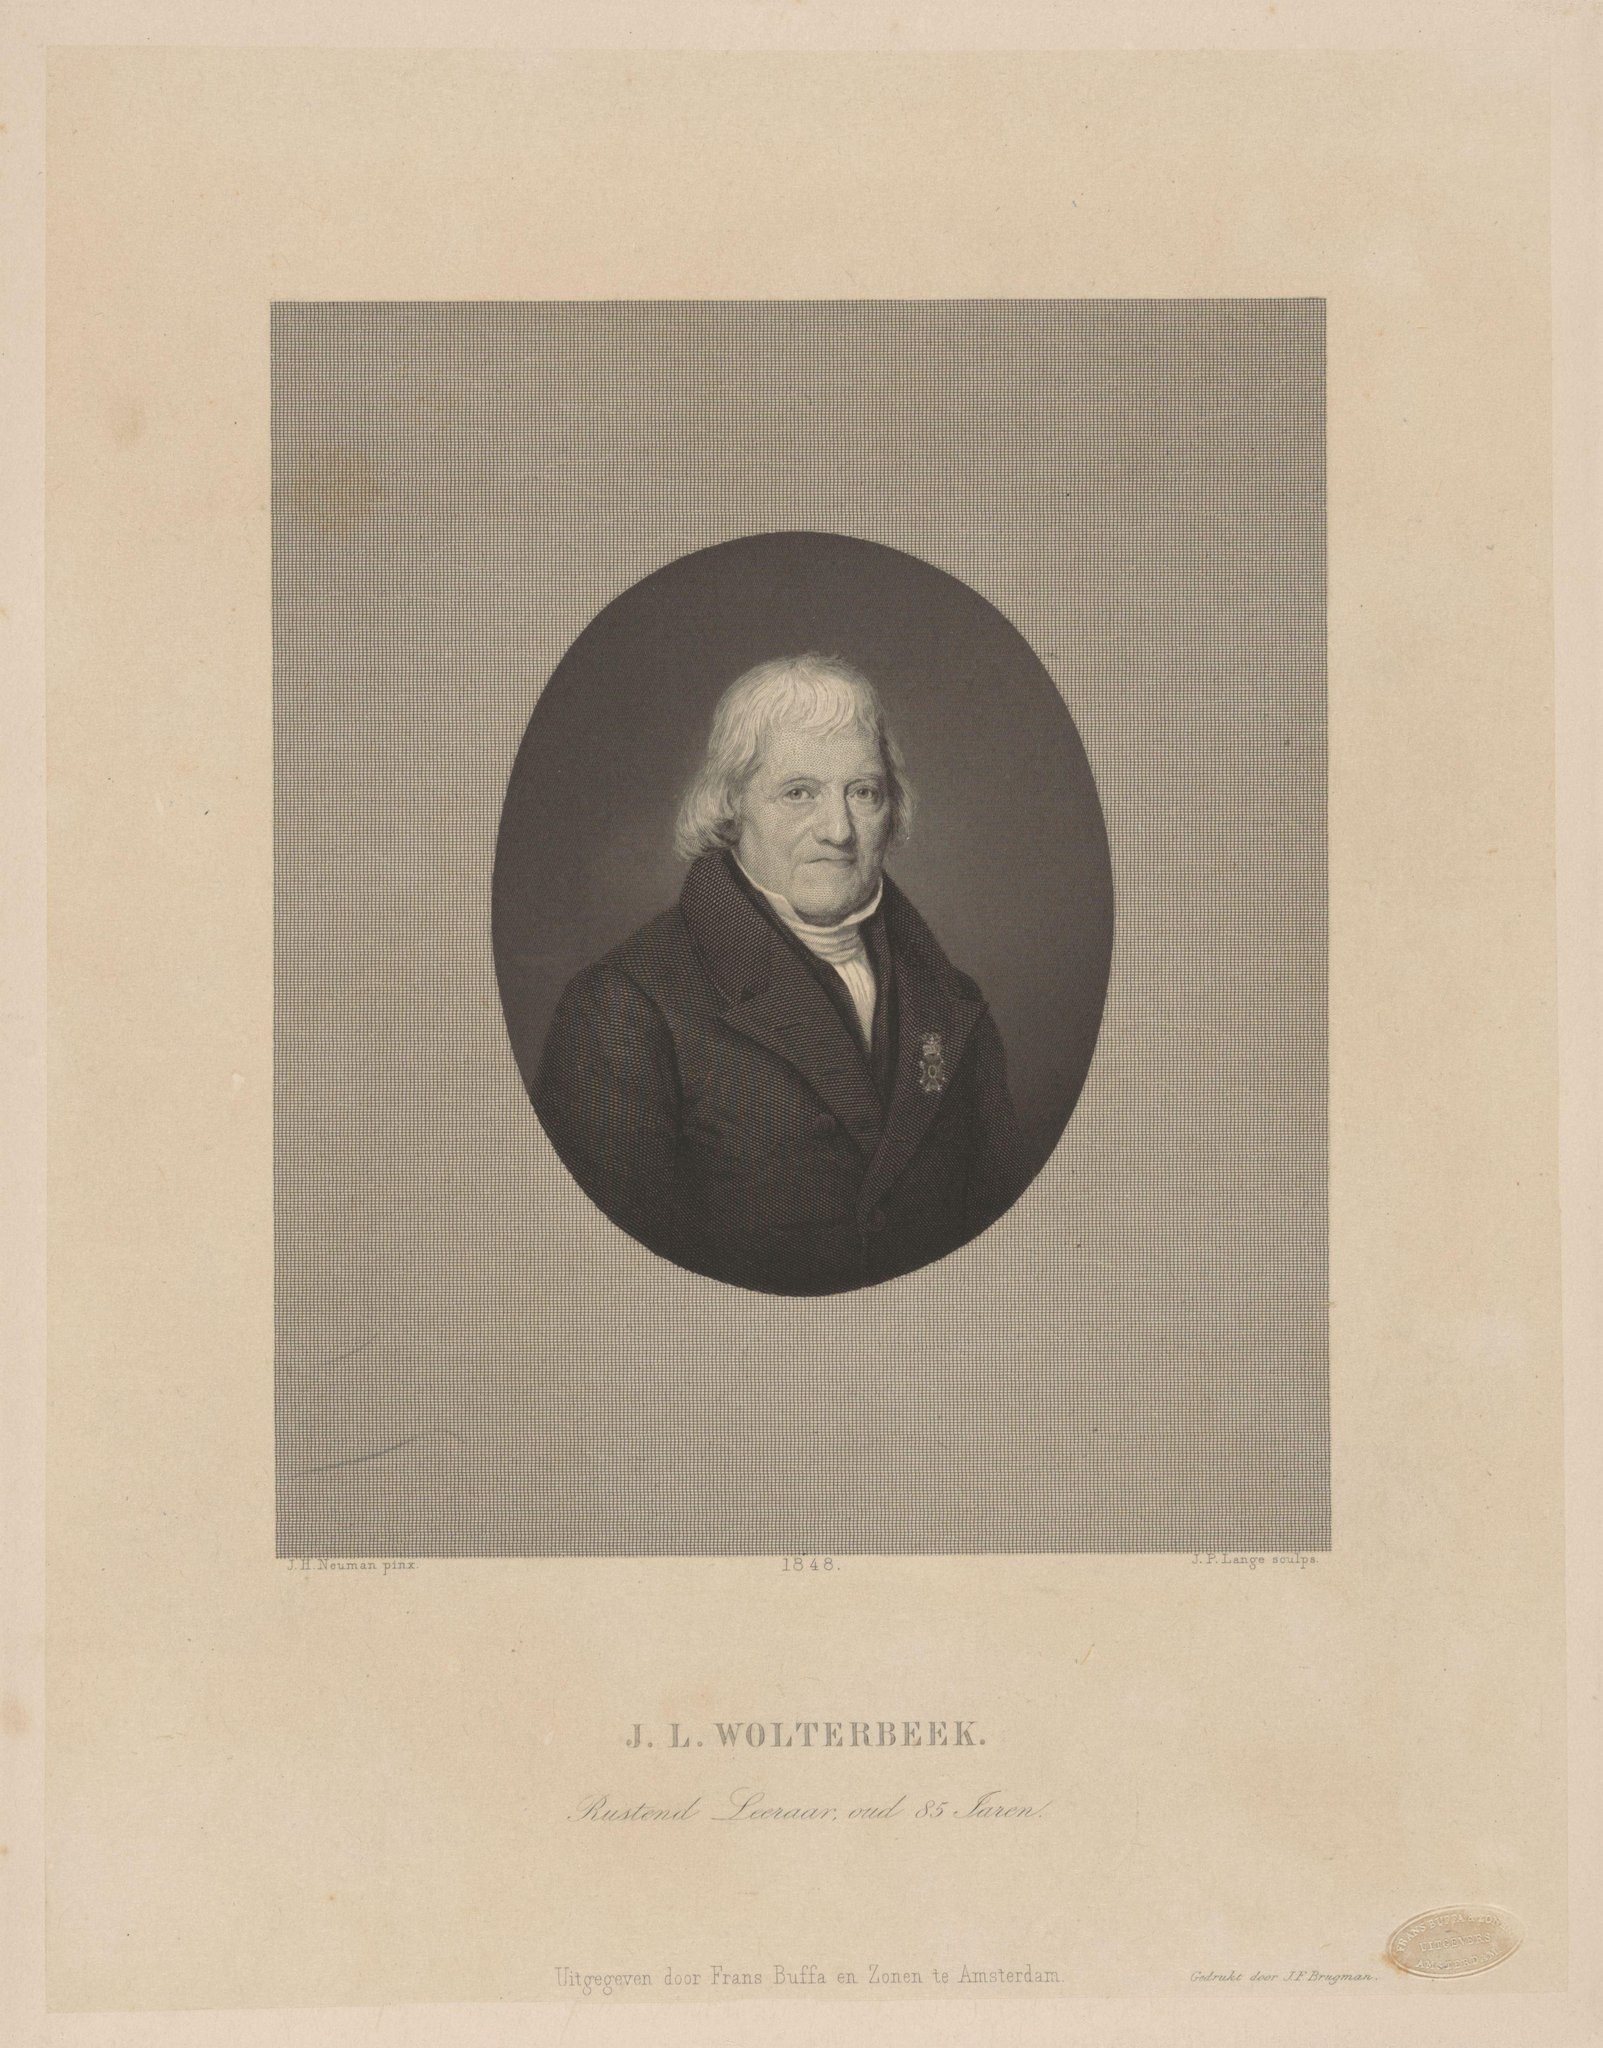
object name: print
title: Portret van Johannes Leonardus Wolterbeek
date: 1848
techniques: printmaking, engraving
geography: netherlands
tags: functionaries and dignitaries ~ protestant churches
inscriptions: collector's mark: Lugt 2228, company name: ‘Frans Buffa & Zonen / Amsterdam / Uitgevers’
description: Portret van de predikant Johannes Leonardus Wolterbeek op 85-jarige leeftijd, buste in ovaal naar rechts.